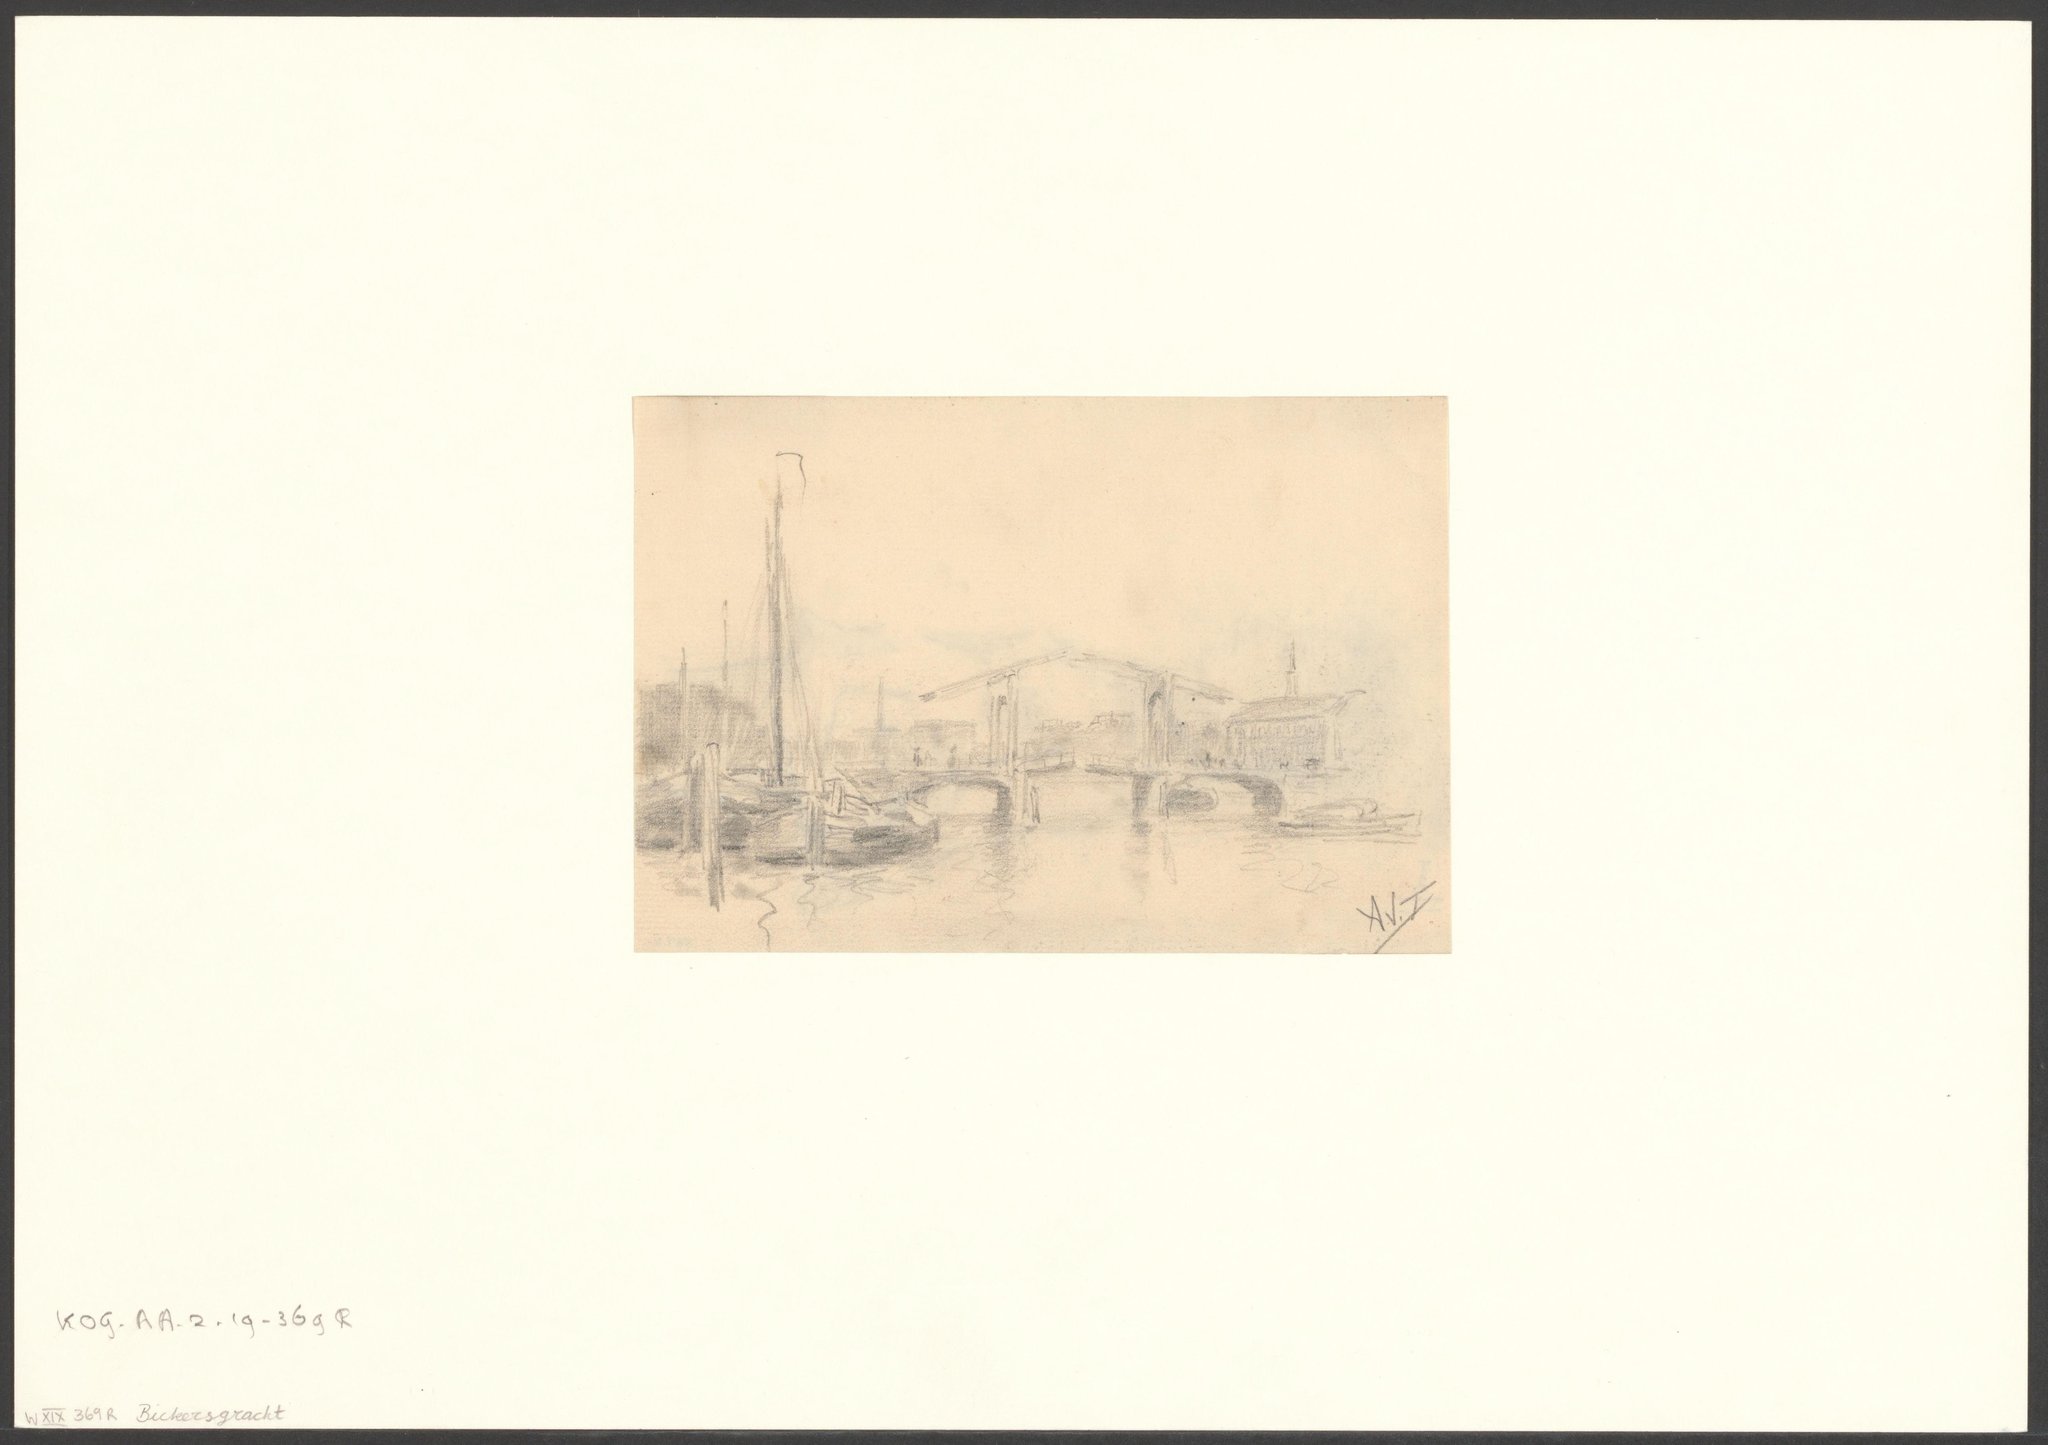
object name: drawing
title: Gezicht op de Amstel gezien in naar de Magere Brug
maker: anthonie van teijn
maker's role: draughtsman, painter, print maker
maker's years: 1863-1943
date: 1873-1943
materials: paper, pencil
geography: amsterdam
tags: city-view in general; 'veduta', river, bridge in city across river, canal, etc.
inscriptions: signature: ‘AV.T’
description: Tekening binnen de Atlas Van Eck ingedeeld op wijknummer 19.